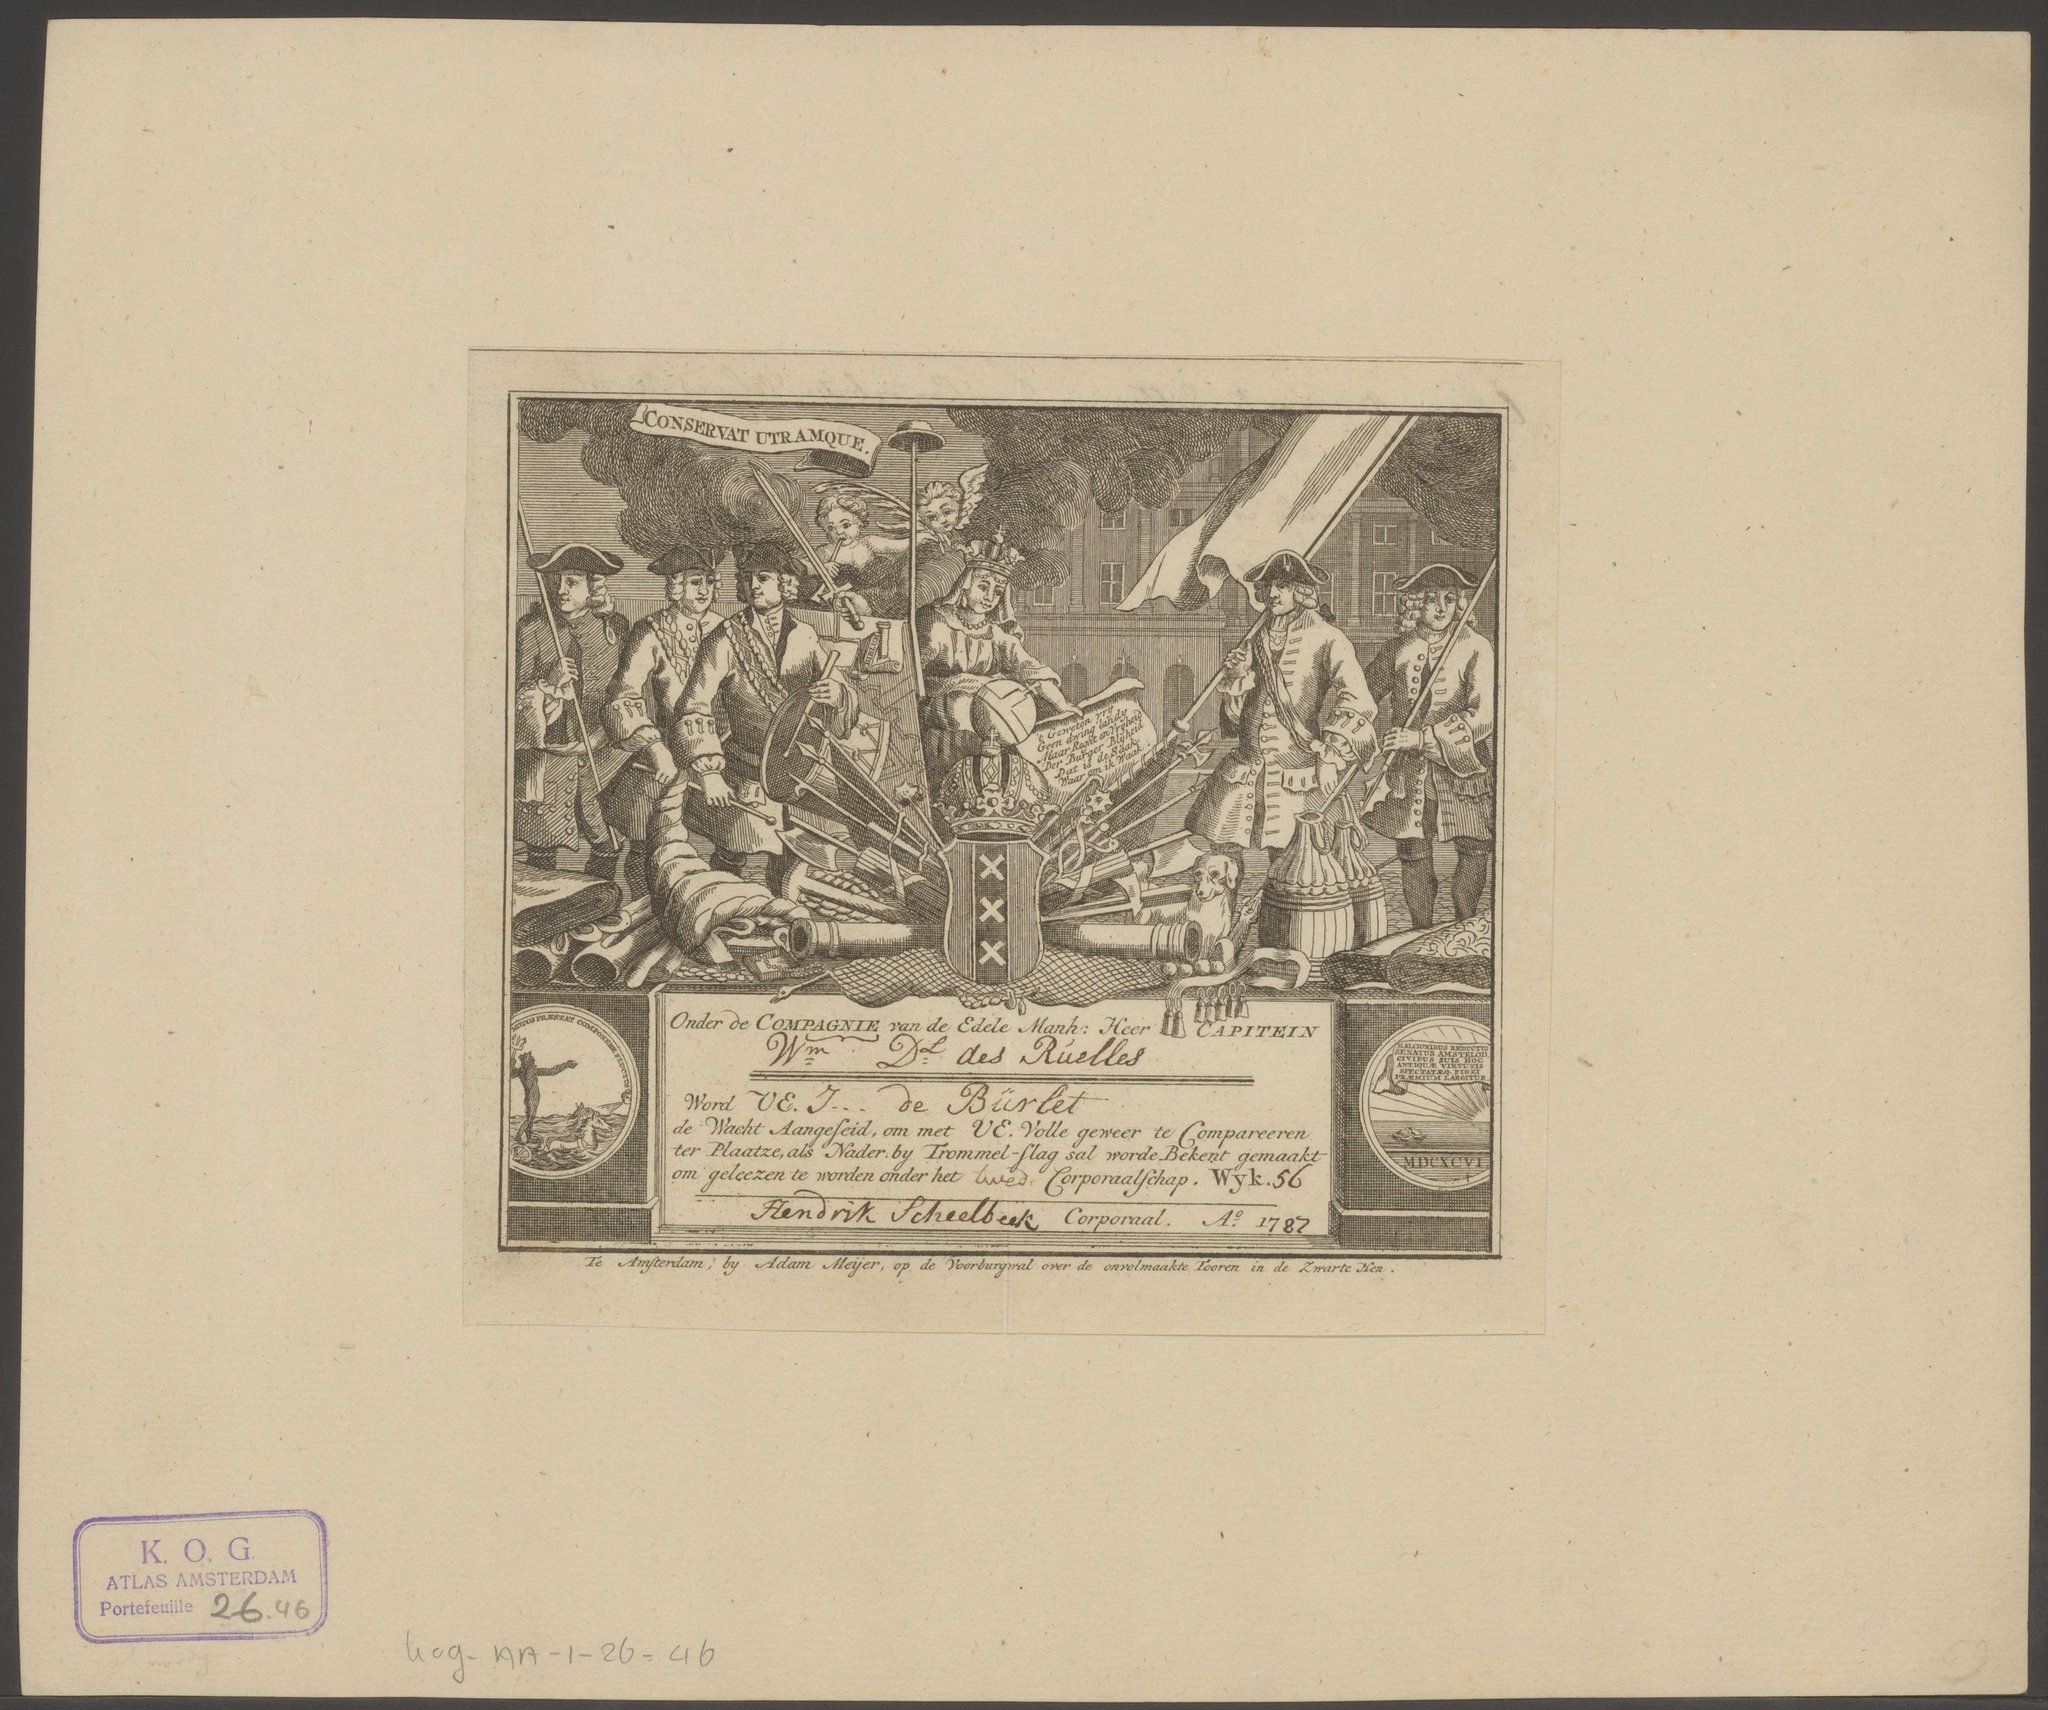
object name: schuttersbiljet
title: Schuttersbrief van kapitein Willem Daniel des Ruelles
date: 1787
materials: paper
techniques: engraving, etching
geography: amsterdam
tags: coat of arms (as symbol of the state, etc.) (+ city; municipal), personification of a city, town-patron(ess), military service (+ citizen soldiery, civil guard, citizen militia), amsterdam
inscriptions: collector's mark: Lugt 1641b, inscription: ‘bekenne ontfange te hebben een jaar contributie volgens accoort / somma f 21 / den 19 july A° 1787 / Hendk Scheelbeek / Corporaal’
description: Schuttersbrief met oproep van kapitein Willem Daniel des Ruelles, gericht aan J. de Burlet, om zich bij het tweede korporaalschap van Hendrik Scheelbeek van burgerwijk LVI te Amsterdam te melden. Voorgedrukte brief met open delen die met pen zijn ingevuld. Onderwerpsrubriek binnen de Atlas Amsterdam: Schutters-oproepingsbriefjes.